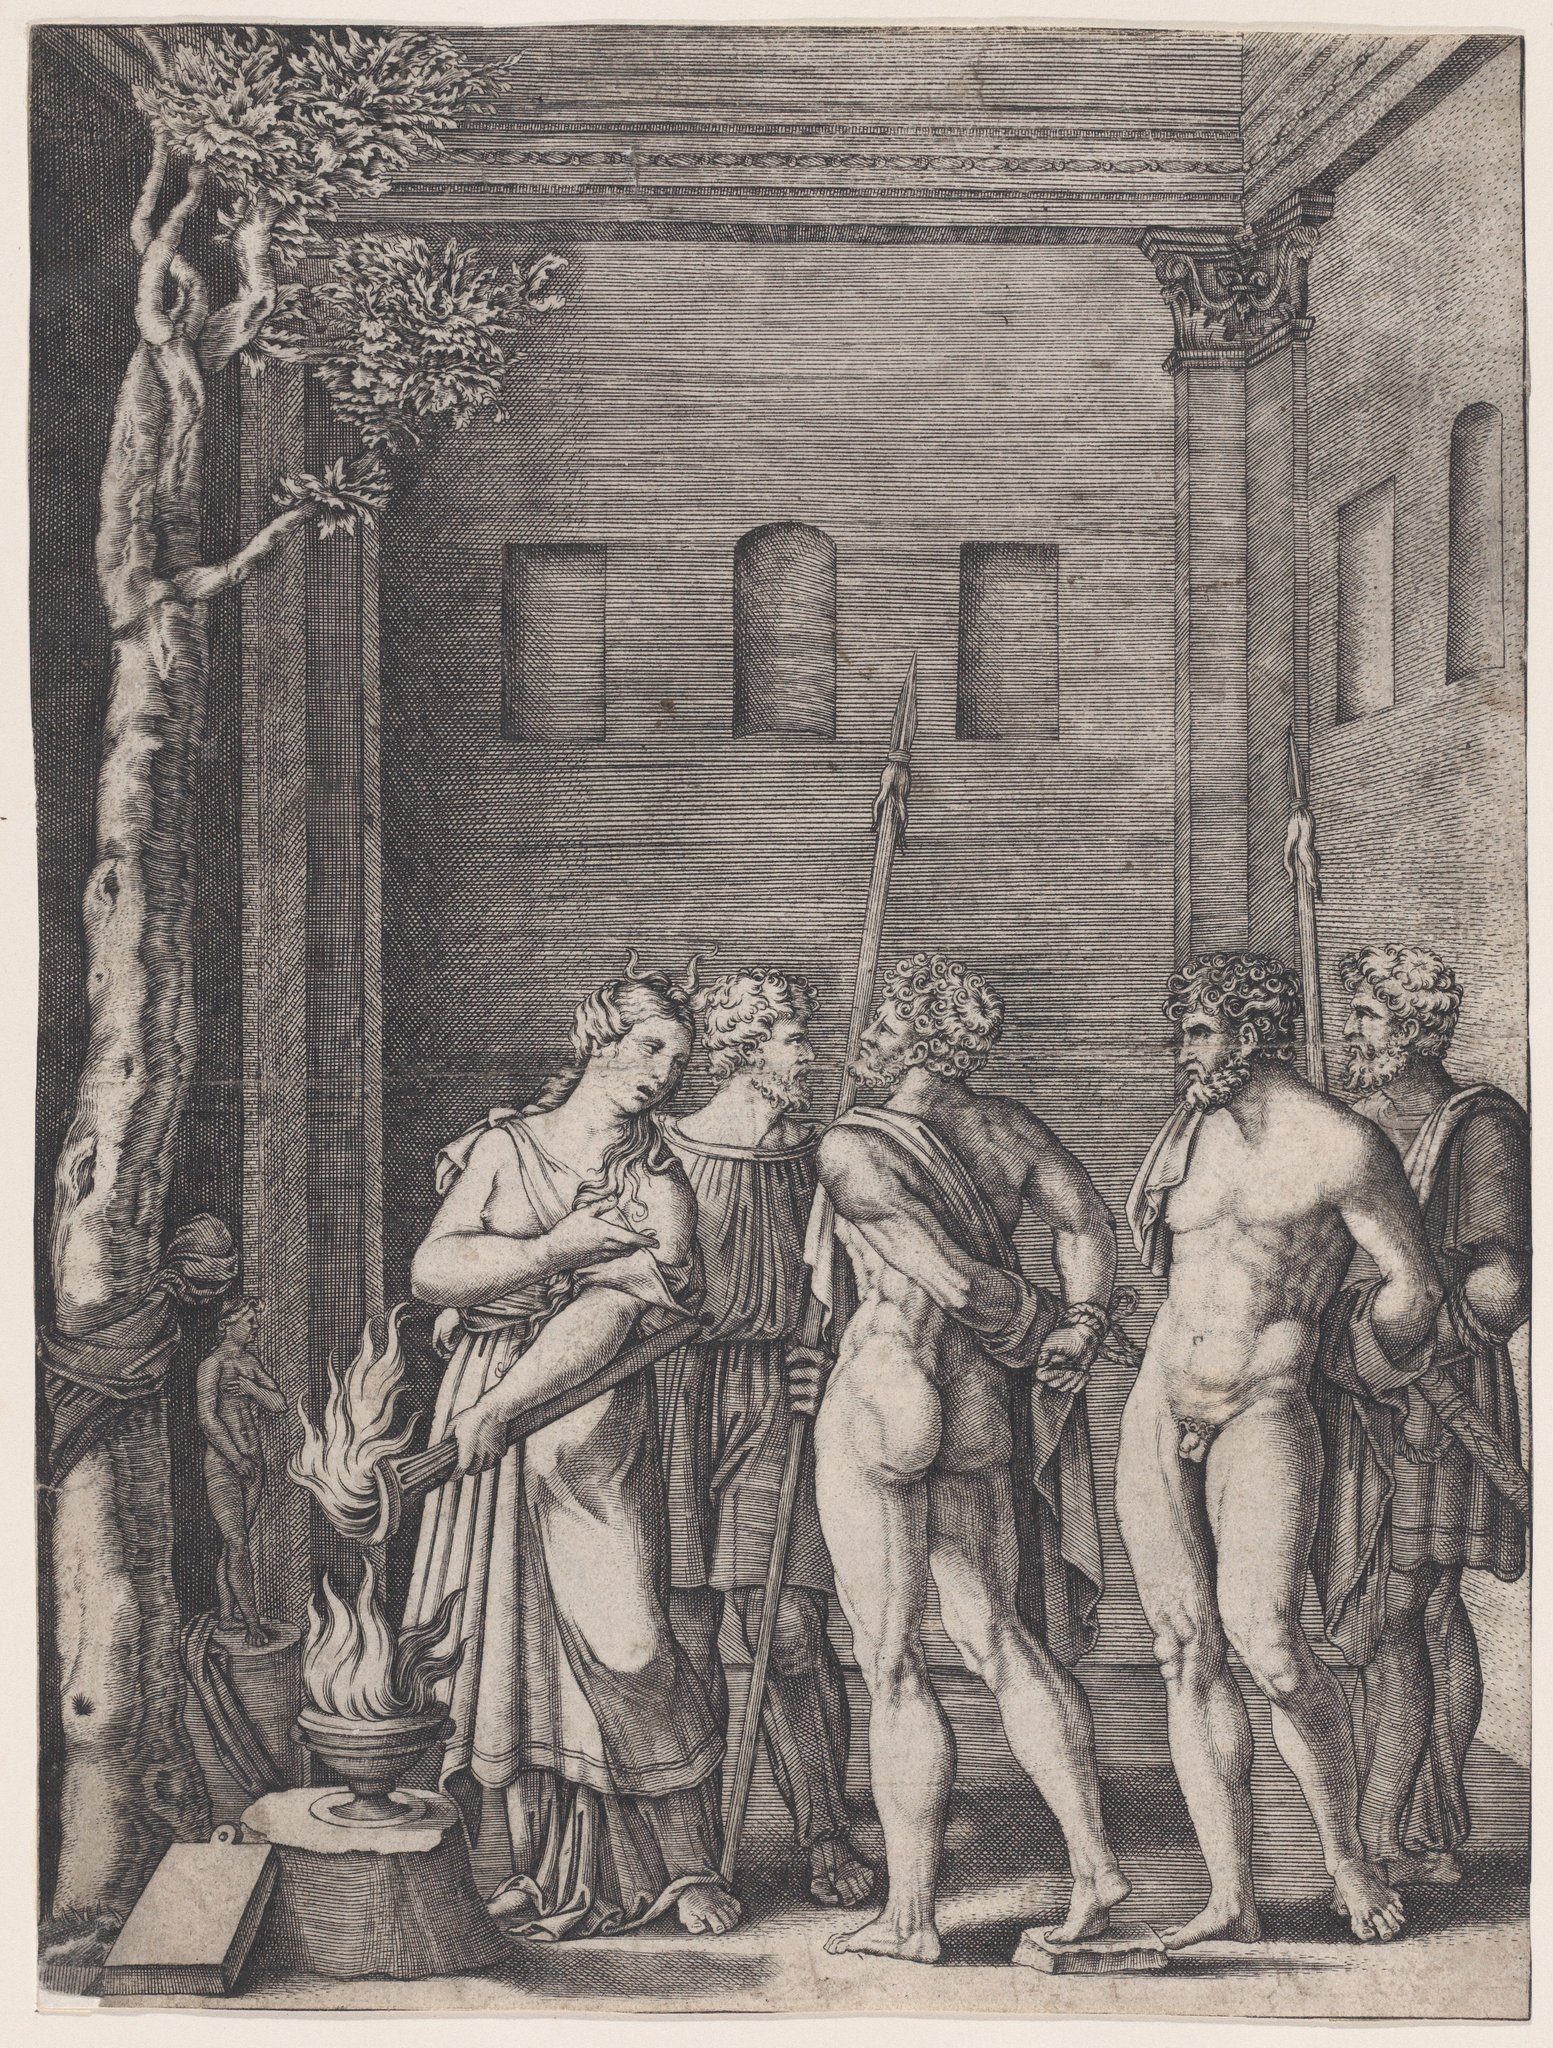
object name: print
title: Iphigenia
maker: agostino veneziano (agostino dei musi)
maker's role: artist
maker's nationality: italian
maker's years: 1490-1536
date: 1514-1536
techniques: engraving